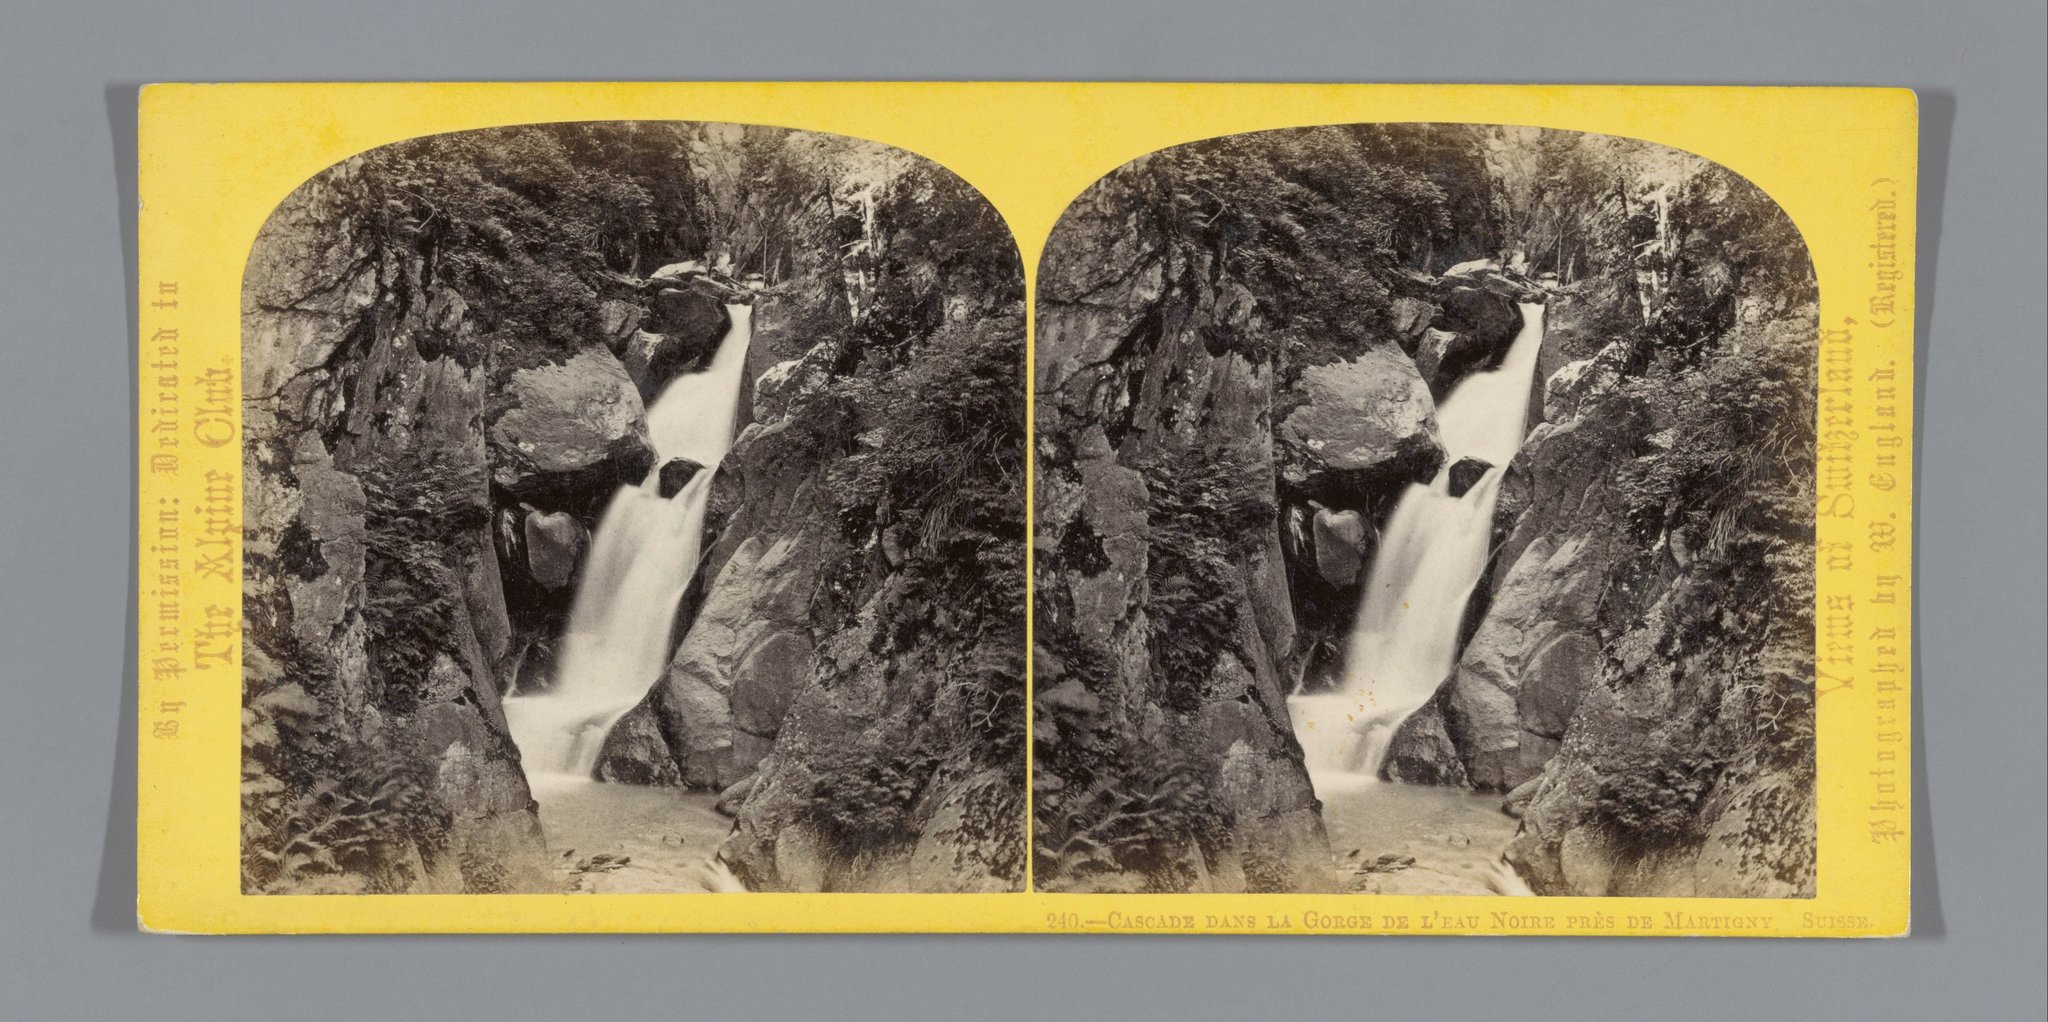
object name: stereograph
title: Cascade dans la gorge de l'eau Noire près de Martigny. Suisse.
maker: william england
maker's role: fotograaf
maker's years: 1816-1896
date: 1850-1863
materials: cardboard, photographic support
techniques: albumen print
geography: wallis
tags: waterfall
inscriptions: inscription: ‘Views of Switzerland, photographed by W. England. (Registered) Under the Special Patronage of the Alpine Club.’, number: ‘240.’